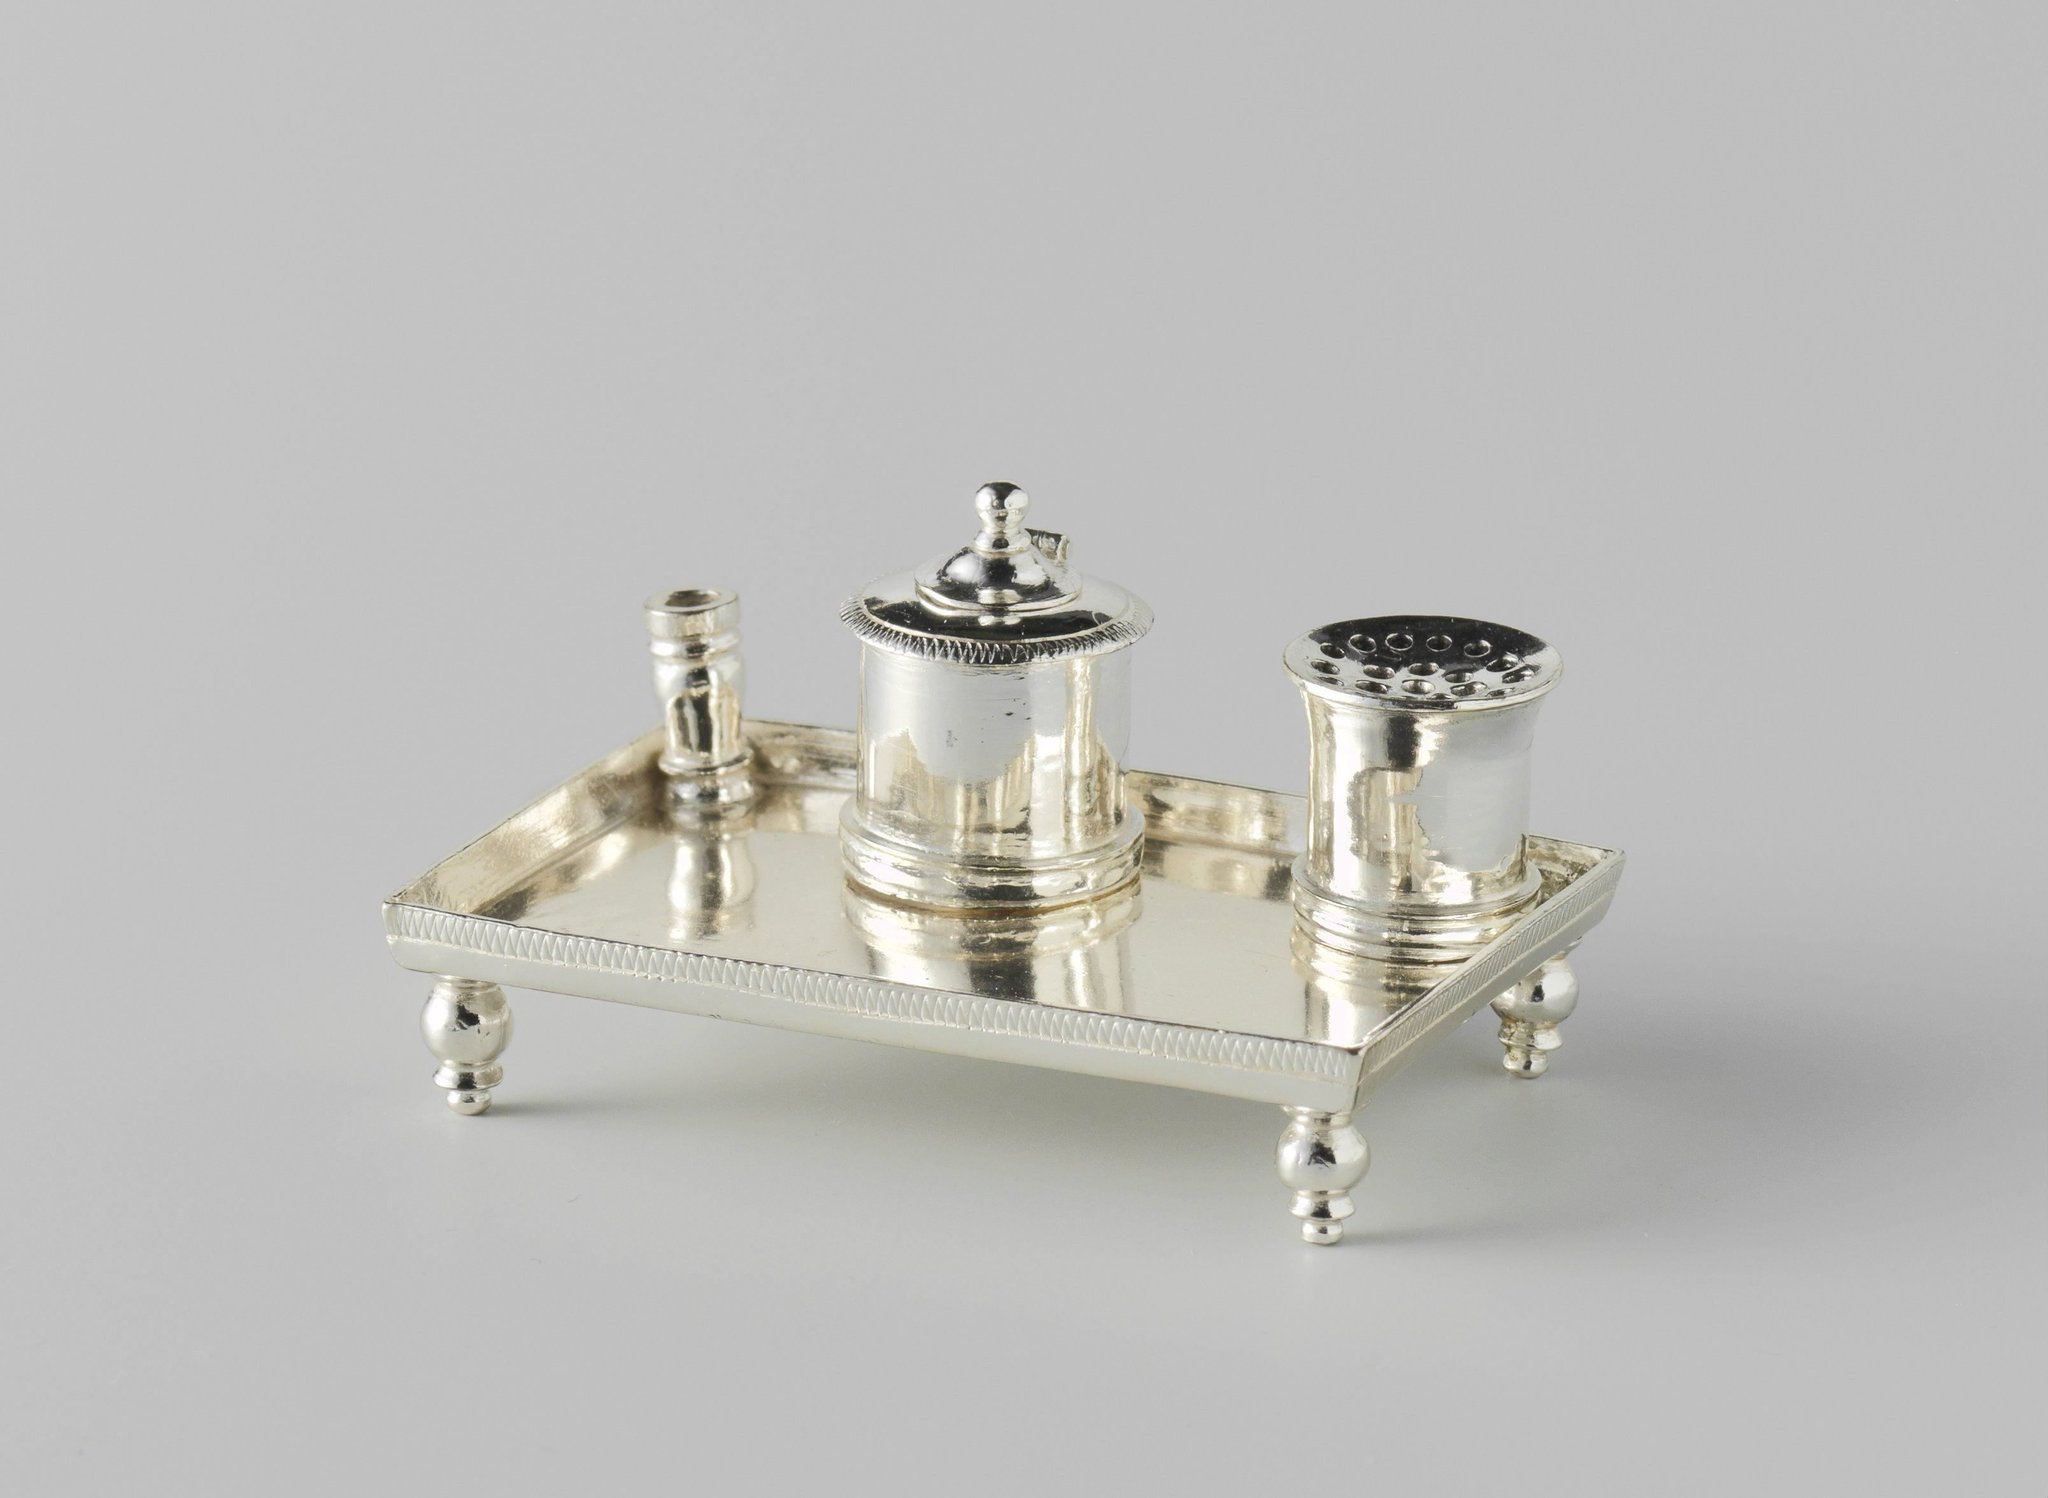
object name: miniature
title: Inktstel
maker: egidius pieter prick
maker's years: 1696-1747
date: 1731-1747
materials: silver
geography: amsterdam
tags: ink-well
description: Inktstel bestaande uit een langwerpig blad op poten met daarop bevestigd: een pennehouder, een inktpot en een zandstrooier. Het blad heeft een rechte opstaande rand met aan de buitenzijde een gegraveerde zig-zag lijn. Het inktstel is gemerkt: mt.= Egidius Pieter Prick.